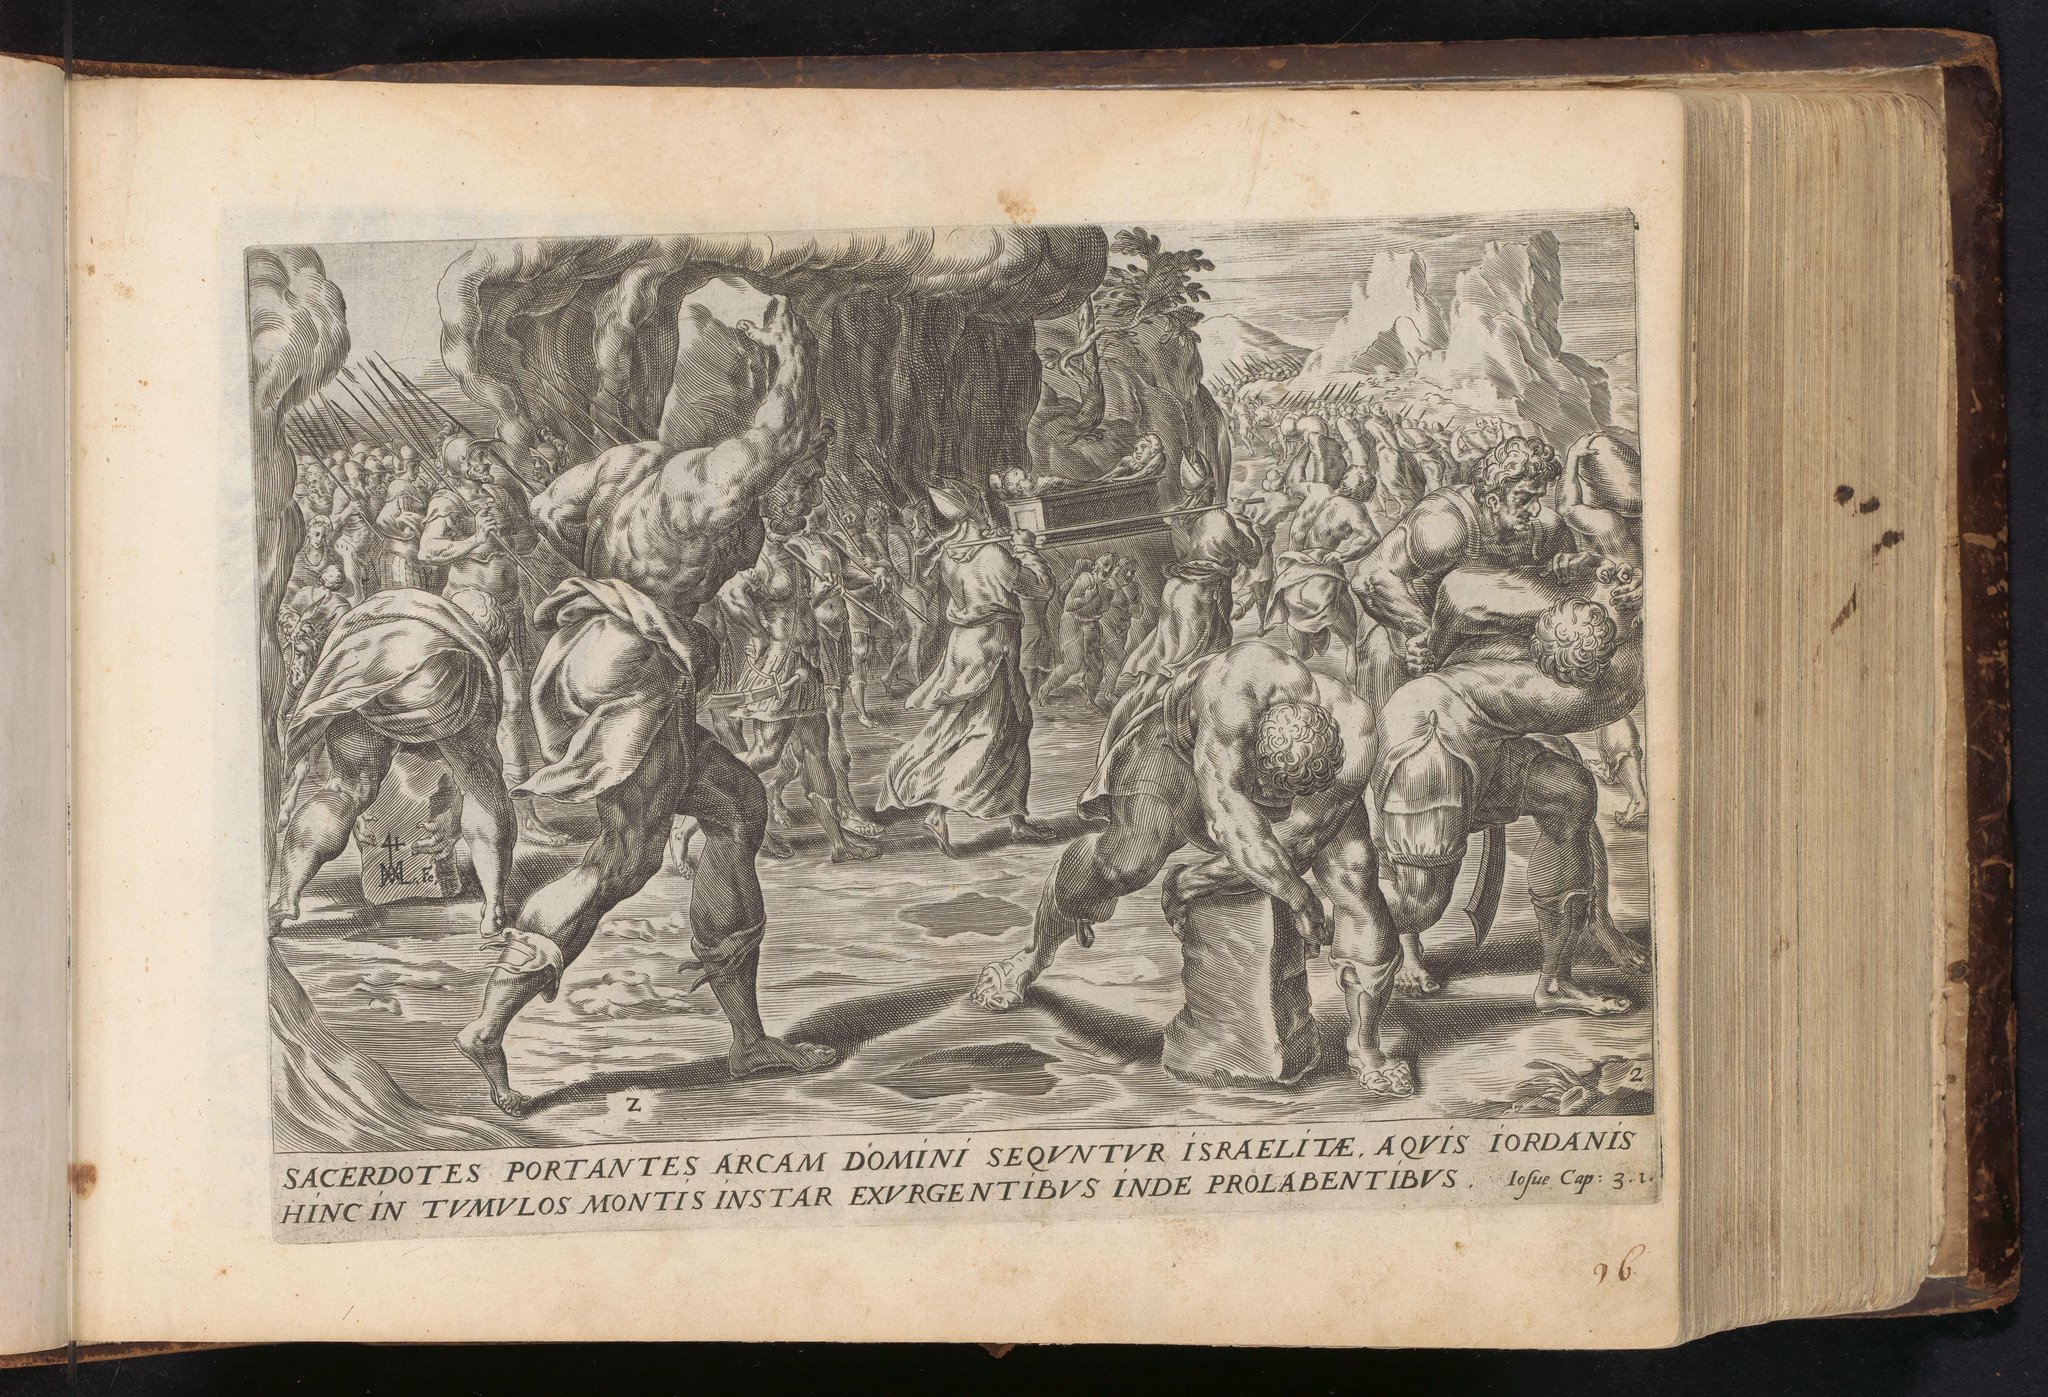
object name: album leaf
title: De geschiedenis van Jozua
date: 1646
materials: paper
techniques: engraving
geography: alkmaar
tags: while the priests with the ark stay in the middle of the jordan and the waters are miraculously dammed, the israelites cross the river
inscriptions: number: ‘96’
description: De Israëlieten trekken over de drooggevallen Jordaan. Enkele van hen nemen stenen van de bodem op. Op de achtergrond staan priesters met de ark van het verbond, daarachter vormt het water van de rivier een dam. Onder de voorstelling een verwijzing in het Latijn naar de Bijbeltekst in Joz. 3:1. Deze prent maakt deel uit van een album.